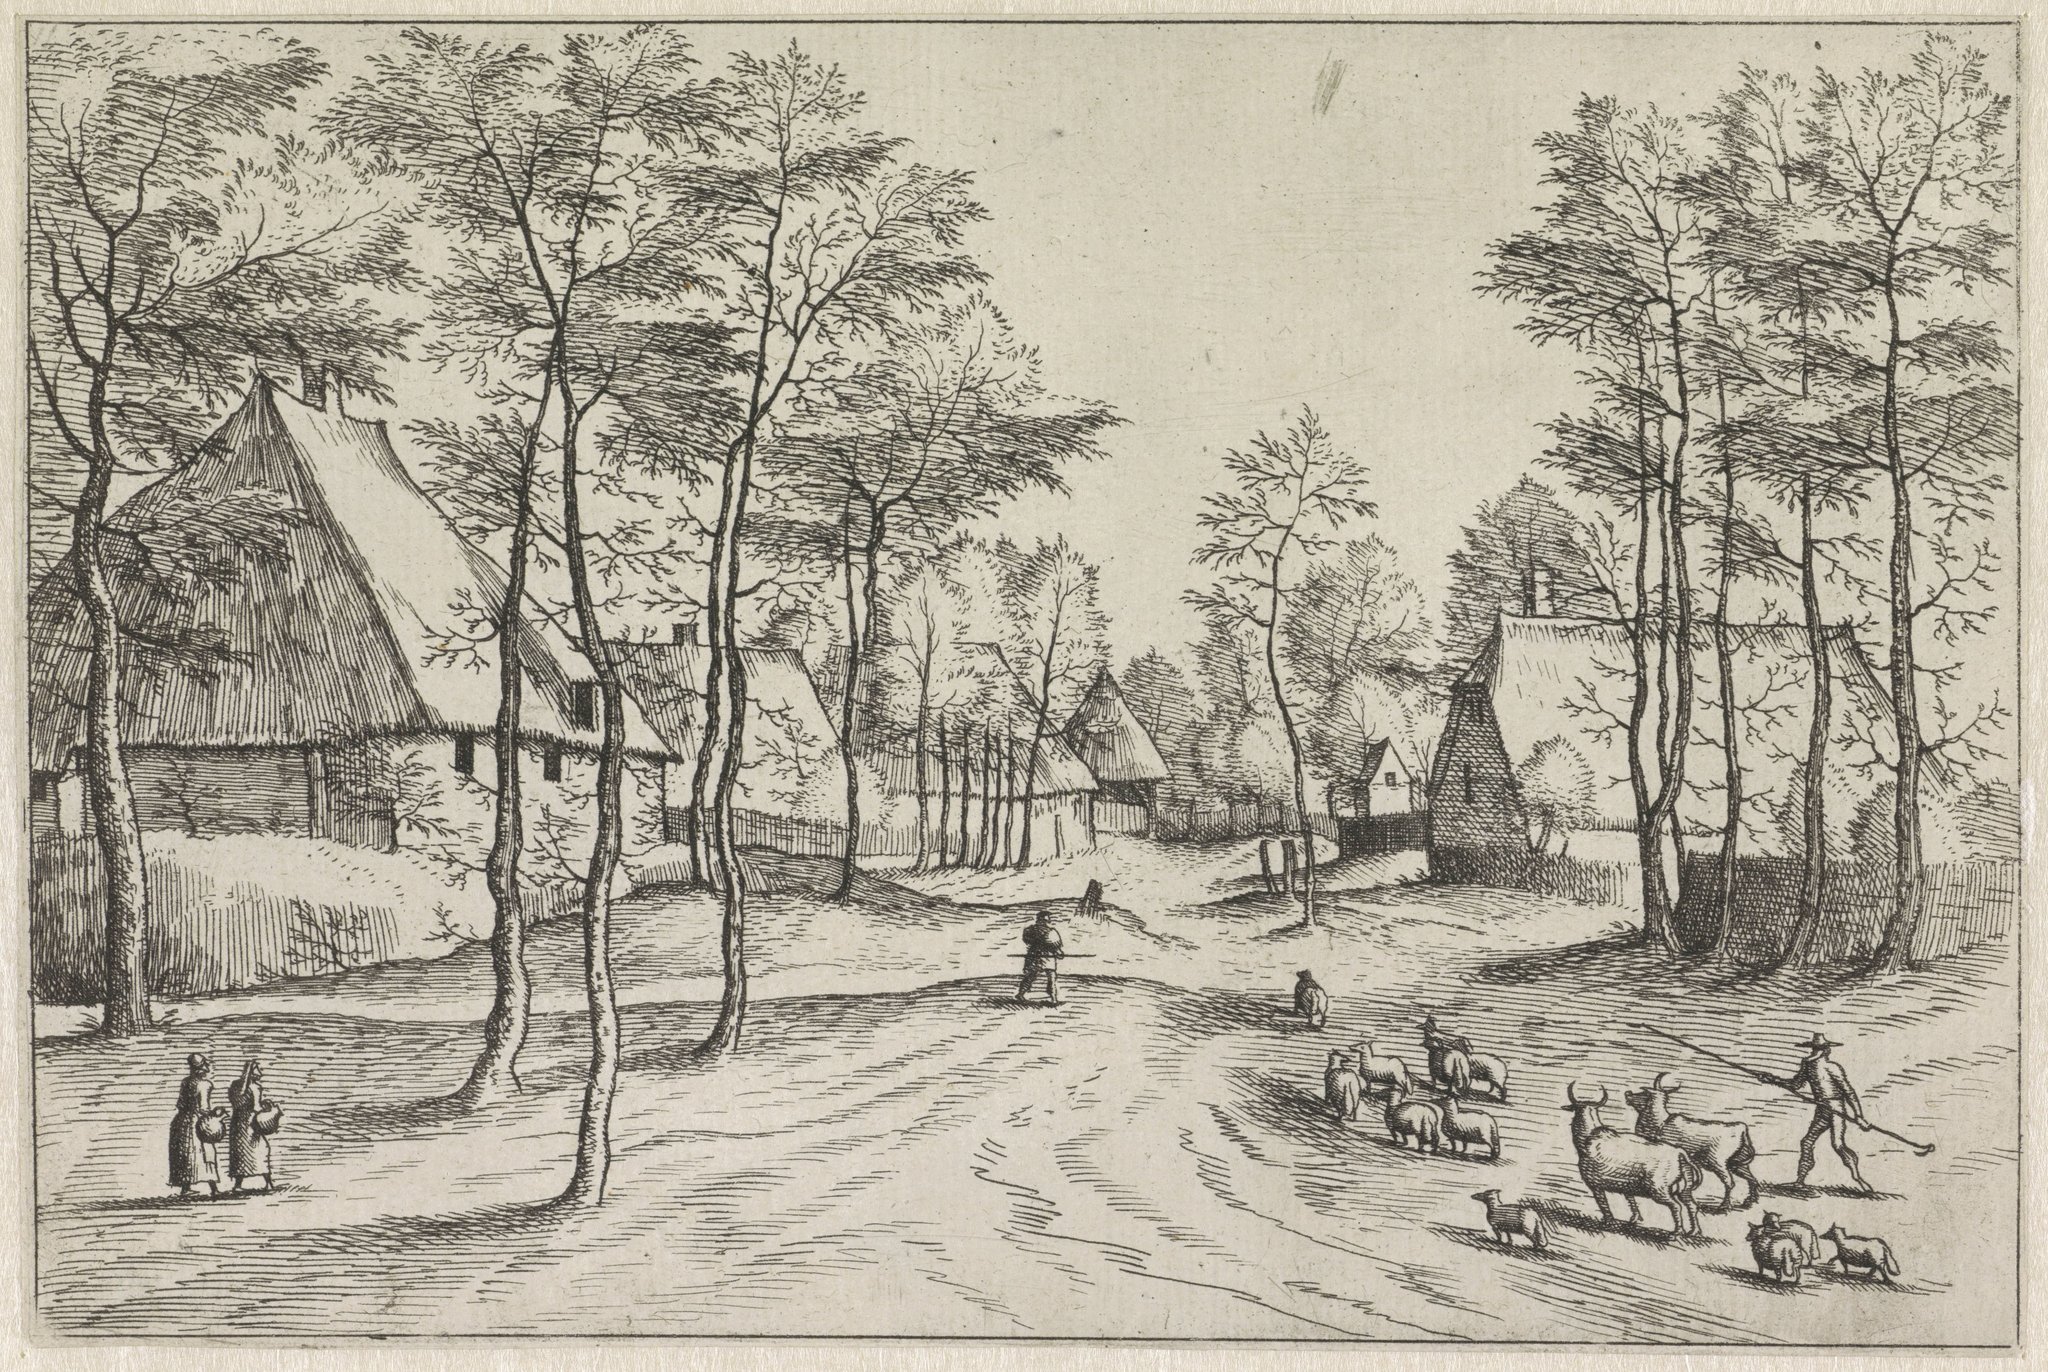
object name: print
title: Kleine landschappen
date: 1559-1561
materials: paper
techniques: etching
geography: antwerp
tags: public road in village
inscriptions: collector's mark: Lugt 2760, collector's mark: Lugt 2228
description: Gezicht op een dorpsstraat met aan weerszijden huizen. Op de weg een herder met vee.